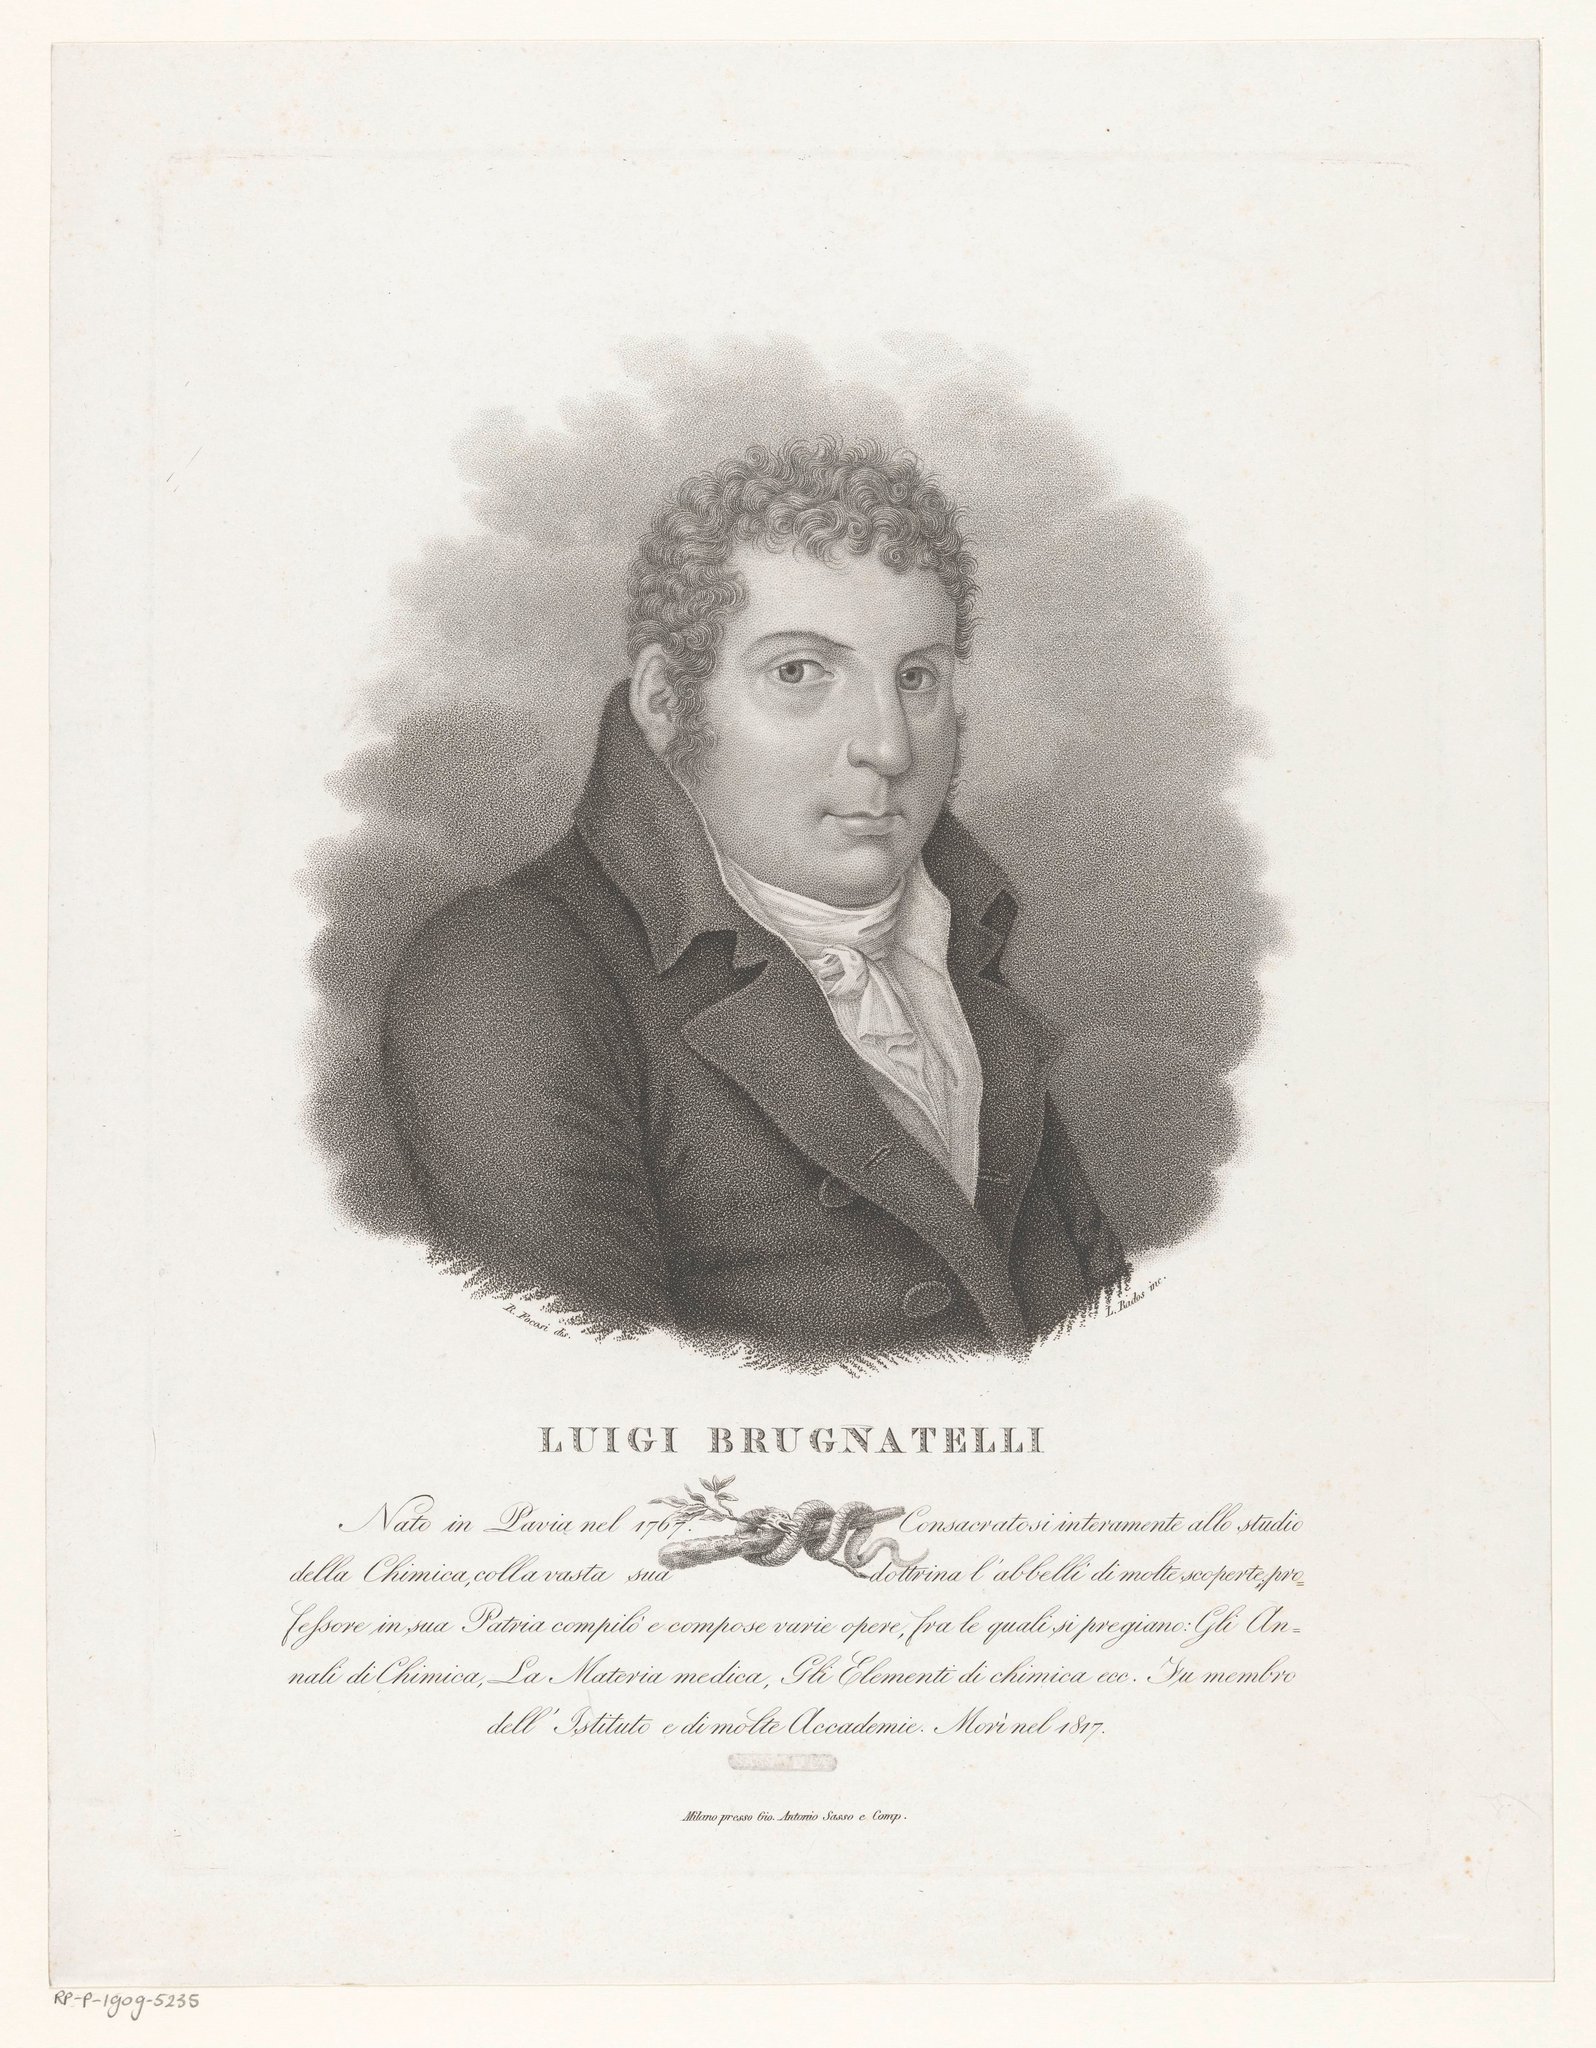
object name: print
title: Portret van Luigi Valentino Brugnatelli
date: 1783-1840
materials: paper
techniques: etching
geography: italy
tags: historical persons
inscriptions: collector's mark: Lugt 2228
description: Deze prent maakt deel uit van een reeks portretprenten.